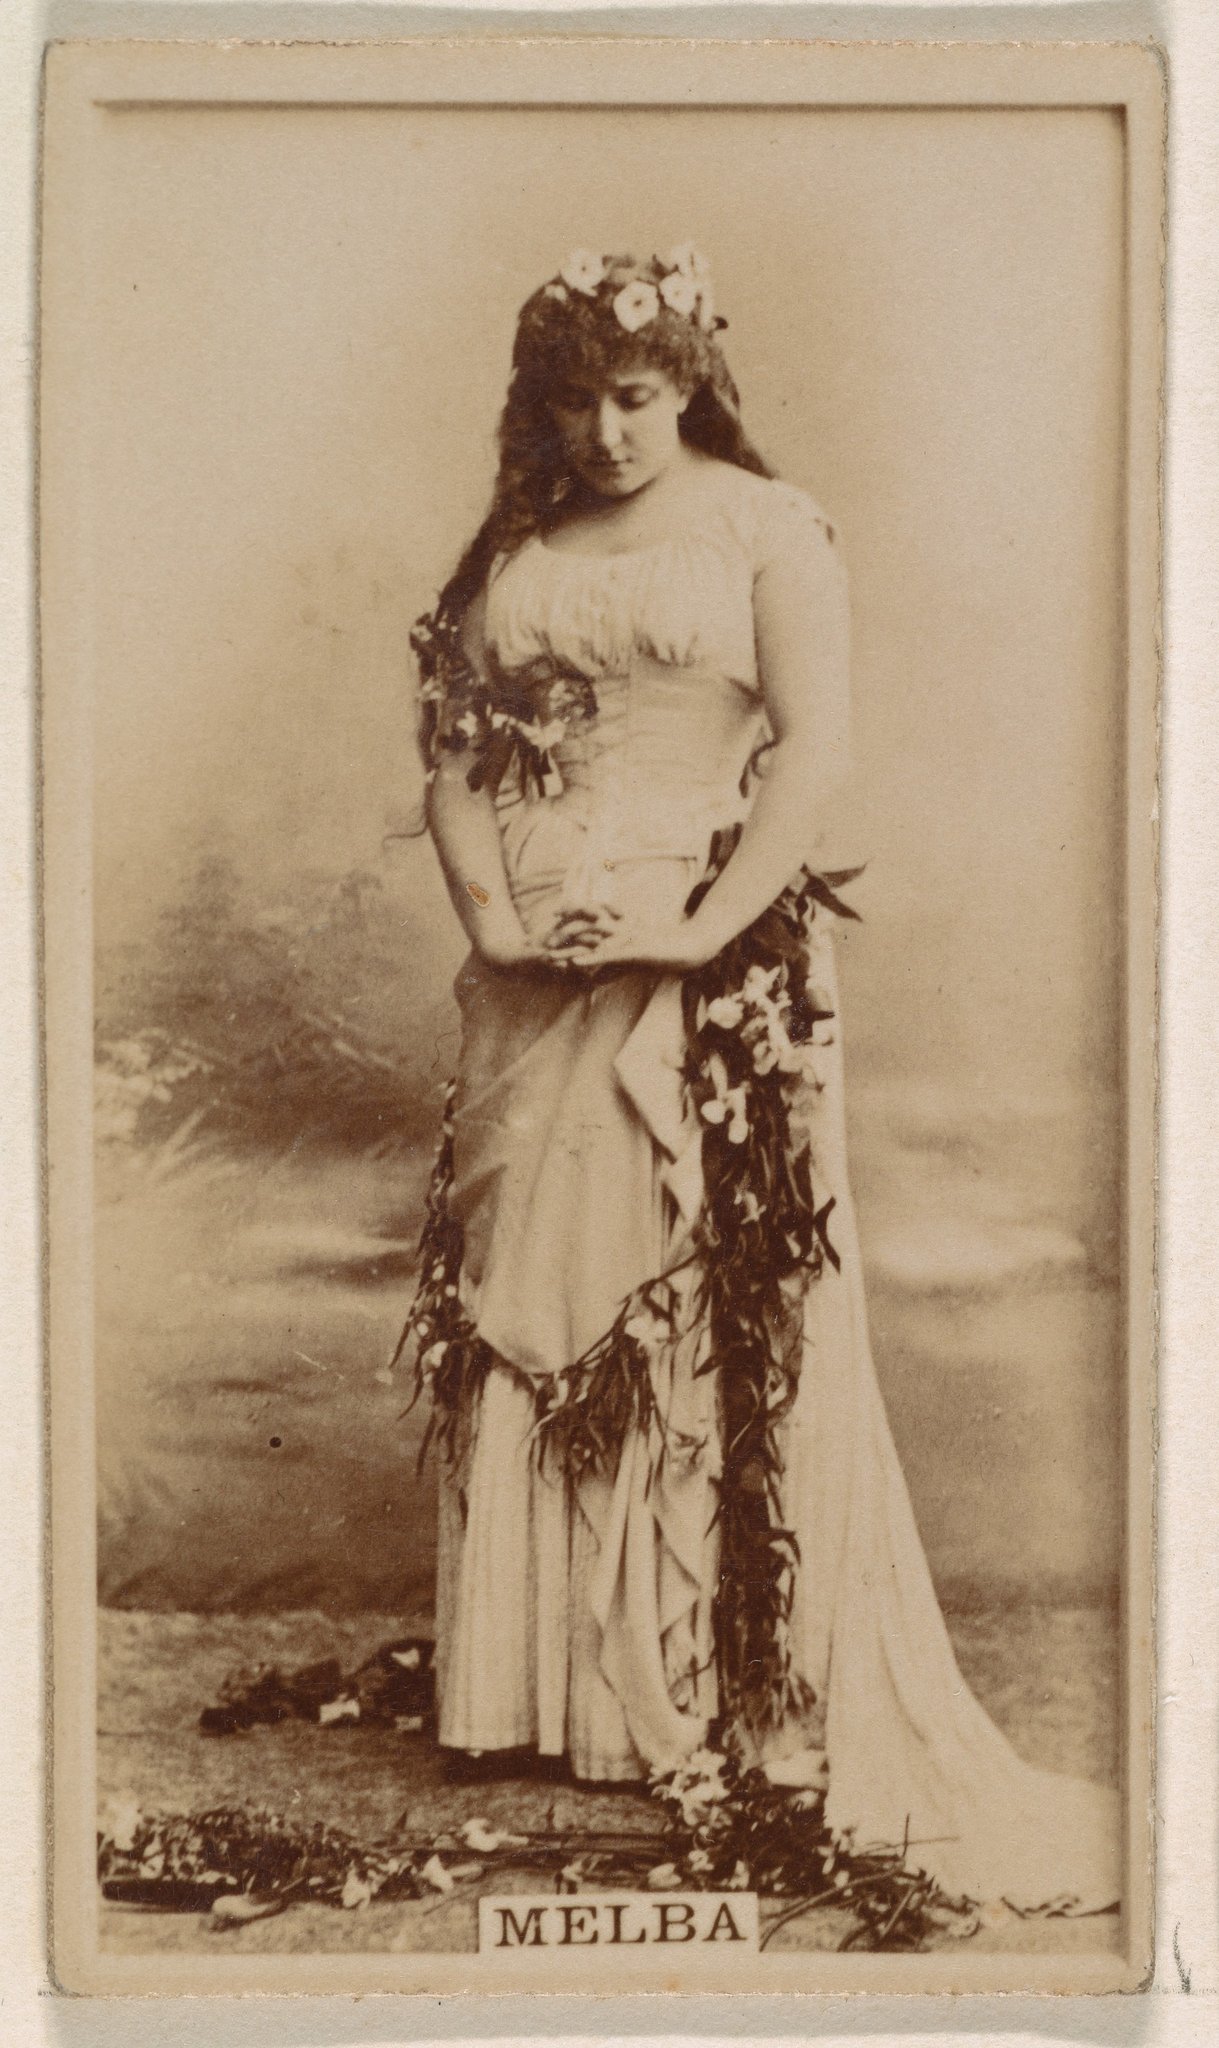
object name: photograph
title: Miss Melba, from the Actresses series (N245) issued by Kinney Brothers to promote Sweet Caporal Cigarettes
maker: kinney brothers tobacco company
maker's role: publisher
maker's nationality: american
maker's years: 1869-2011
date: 1890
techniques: albumen silver print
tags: portraits,women,actresses